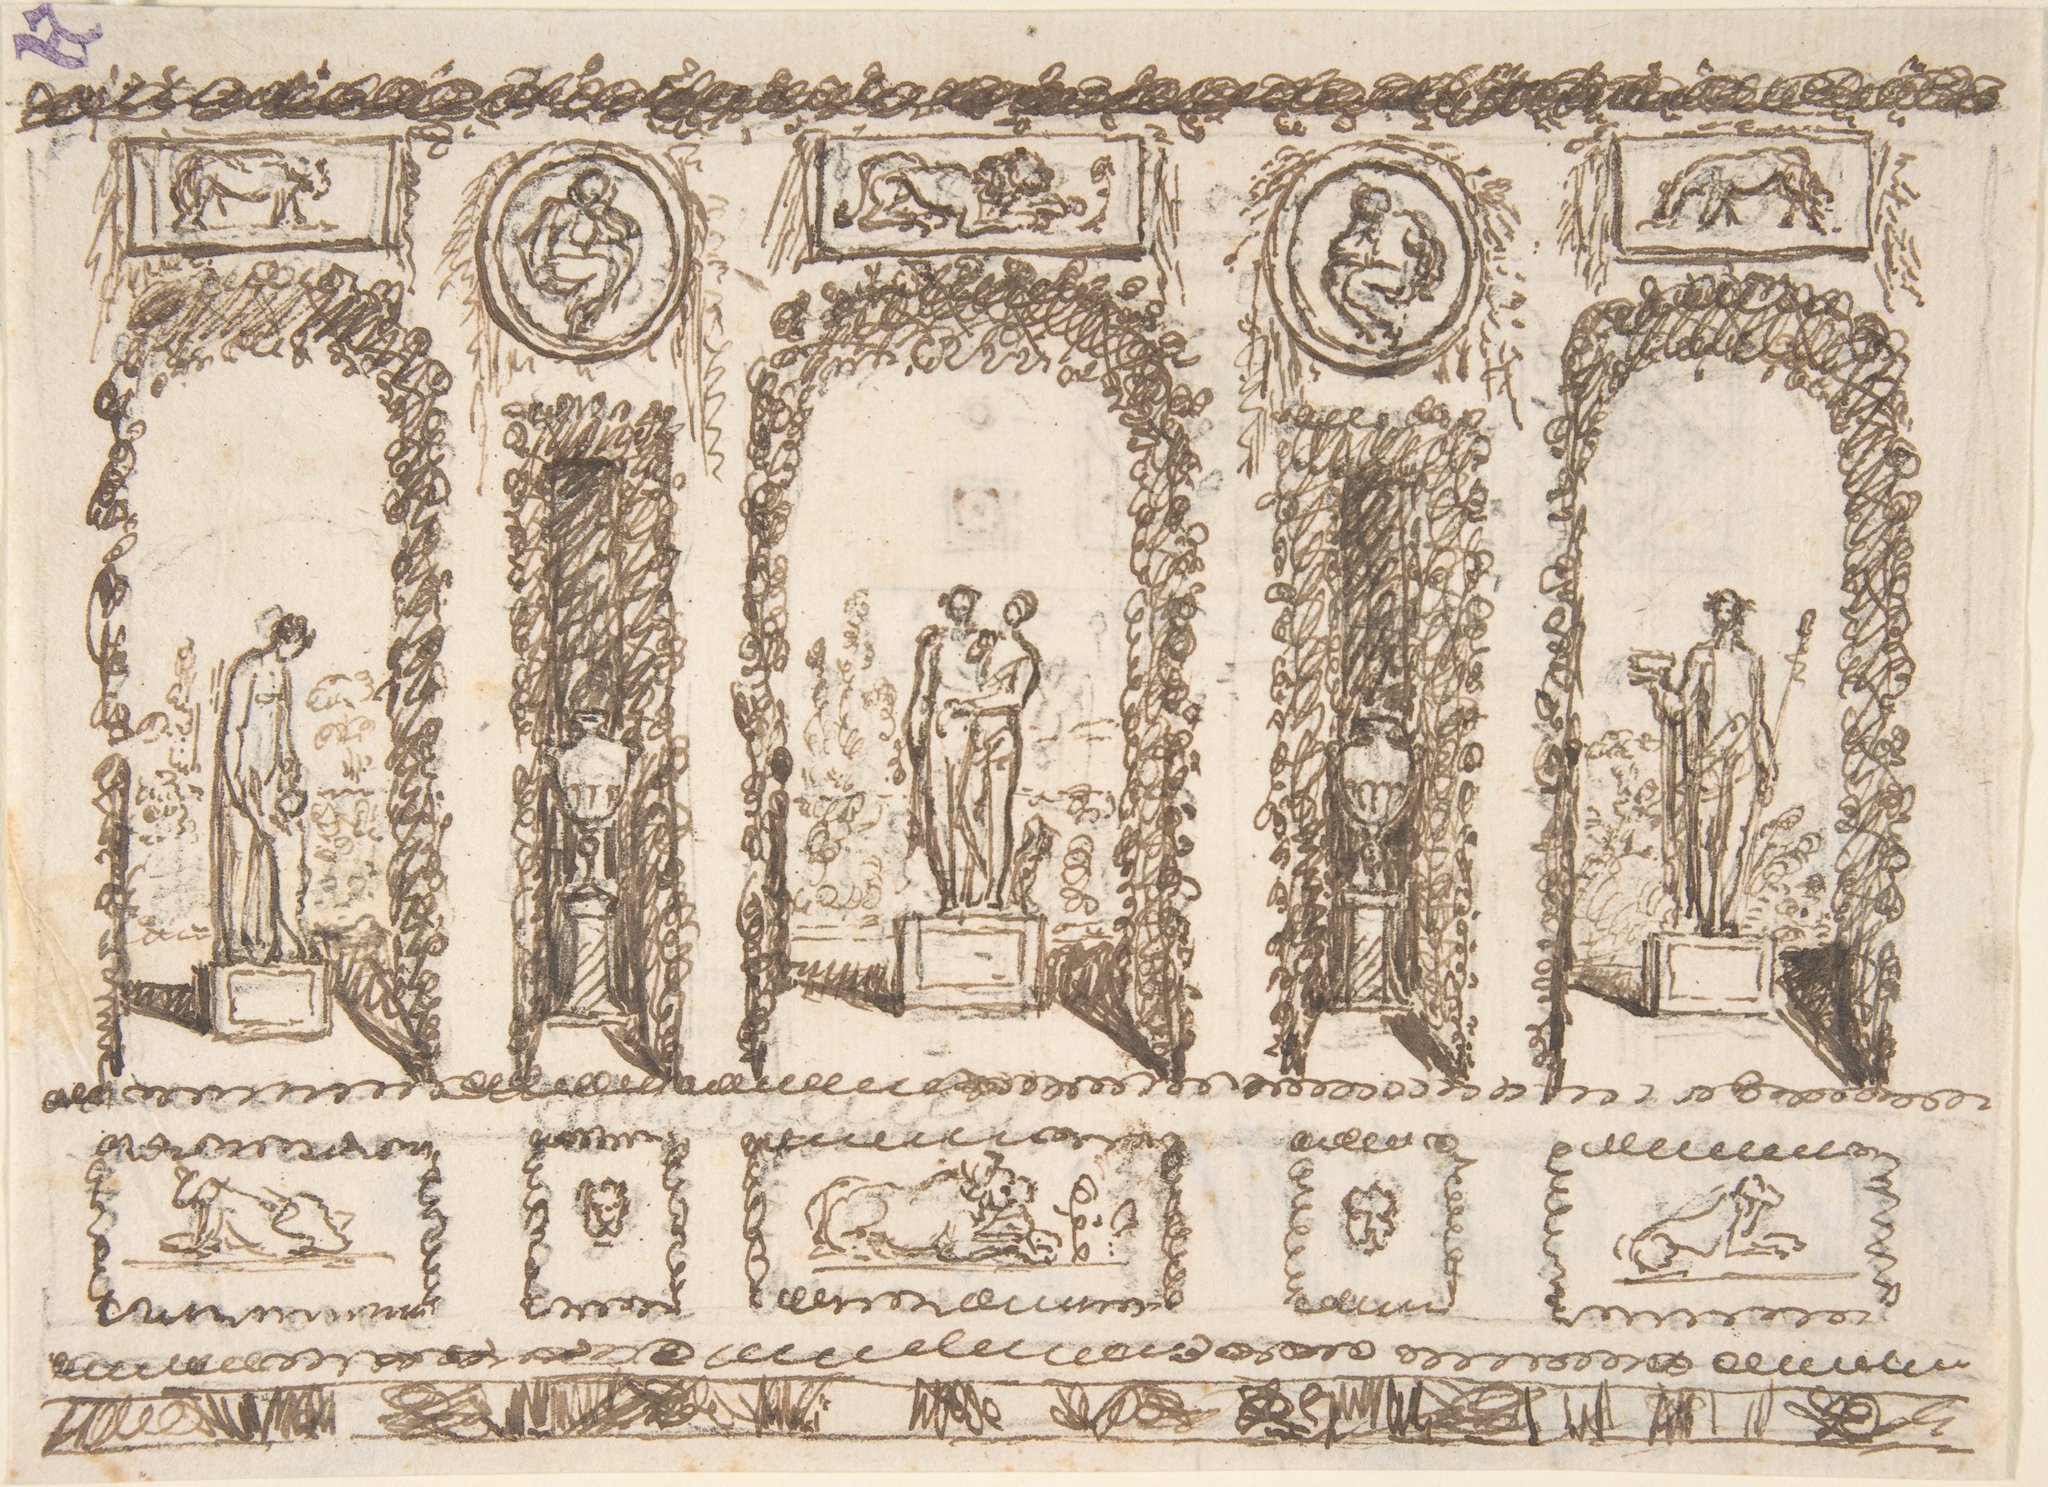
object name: drawing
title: Design for a Wall Decoration of a Conservatory or Grotto with Statues and Vases in Niches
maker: anonymous, italian, 19th century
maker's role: artist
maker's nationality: italian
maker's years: 1800-1900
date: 1800-1900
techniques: pen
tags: human figures,animals,vases